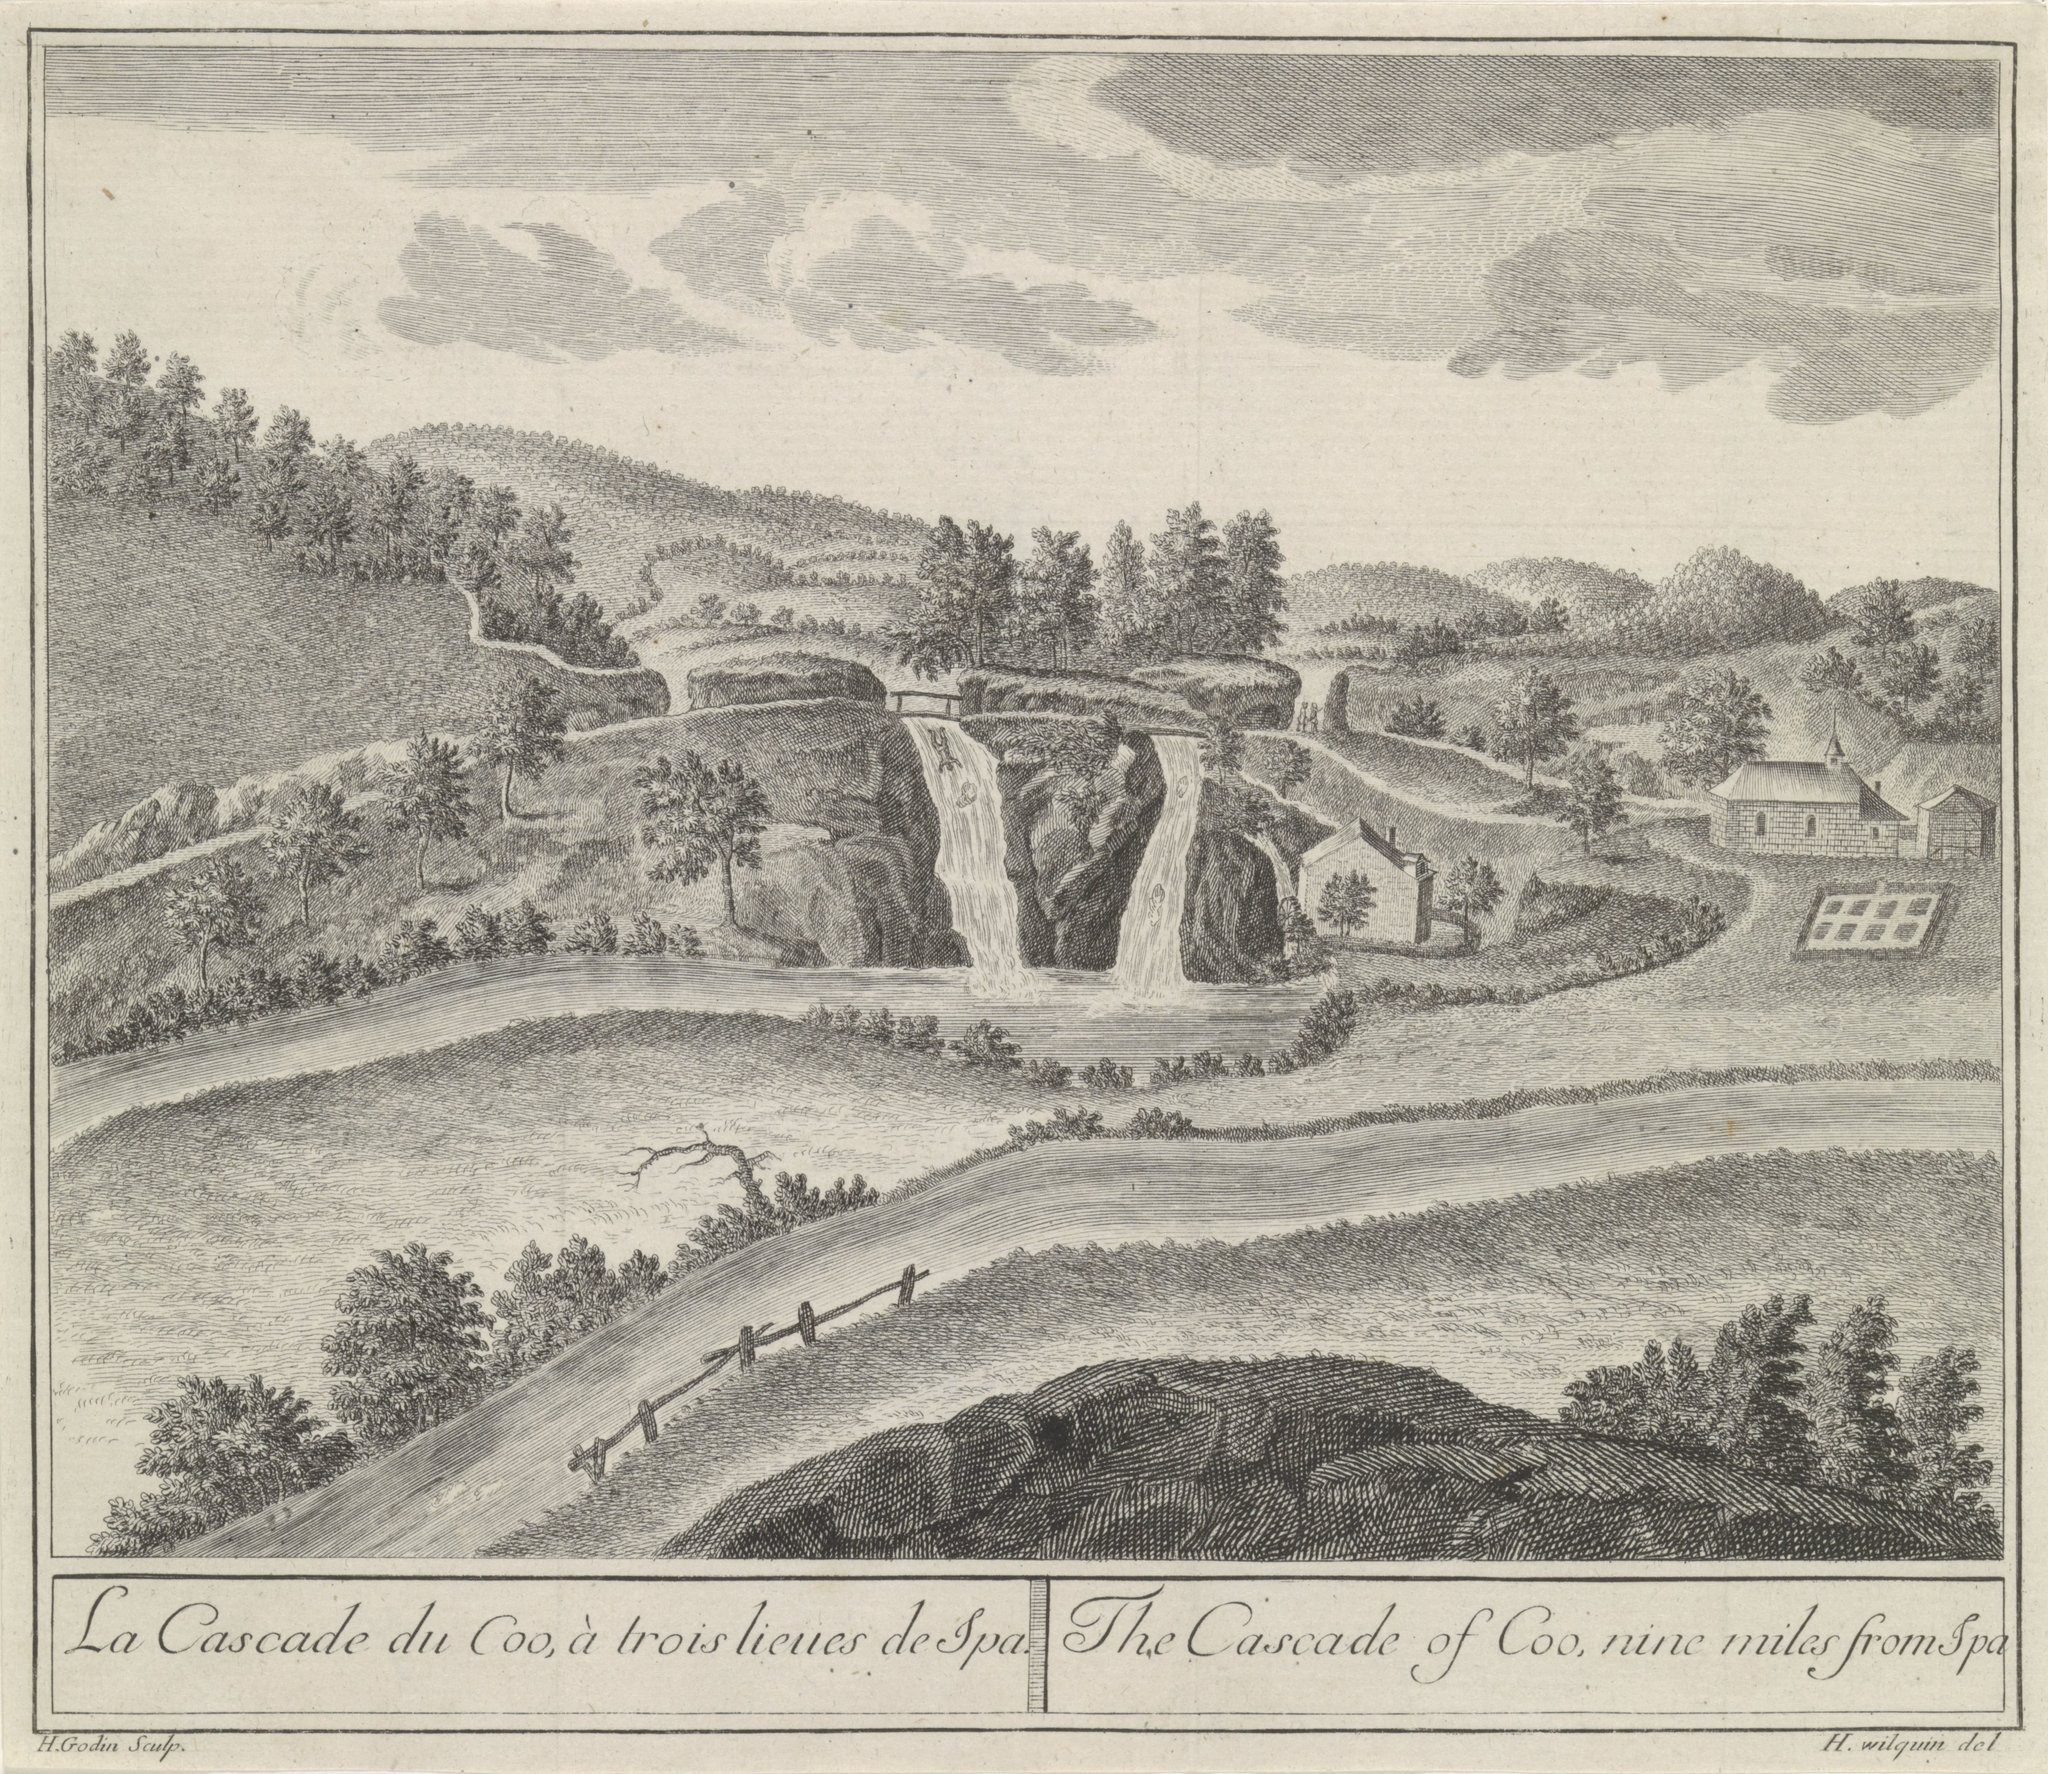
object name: print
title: Gezicht op de Watervallen van Coo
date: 1778-1782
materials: paper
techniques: engraving, etching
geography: liège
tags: waterfall (+ landscape with figures, staffage)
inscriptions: collector's mark: Lugt 2228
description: De Watervallen van Coo. Een man valt van de watervallen. De prent is deel van een serie met landschappen in en nabij Spa